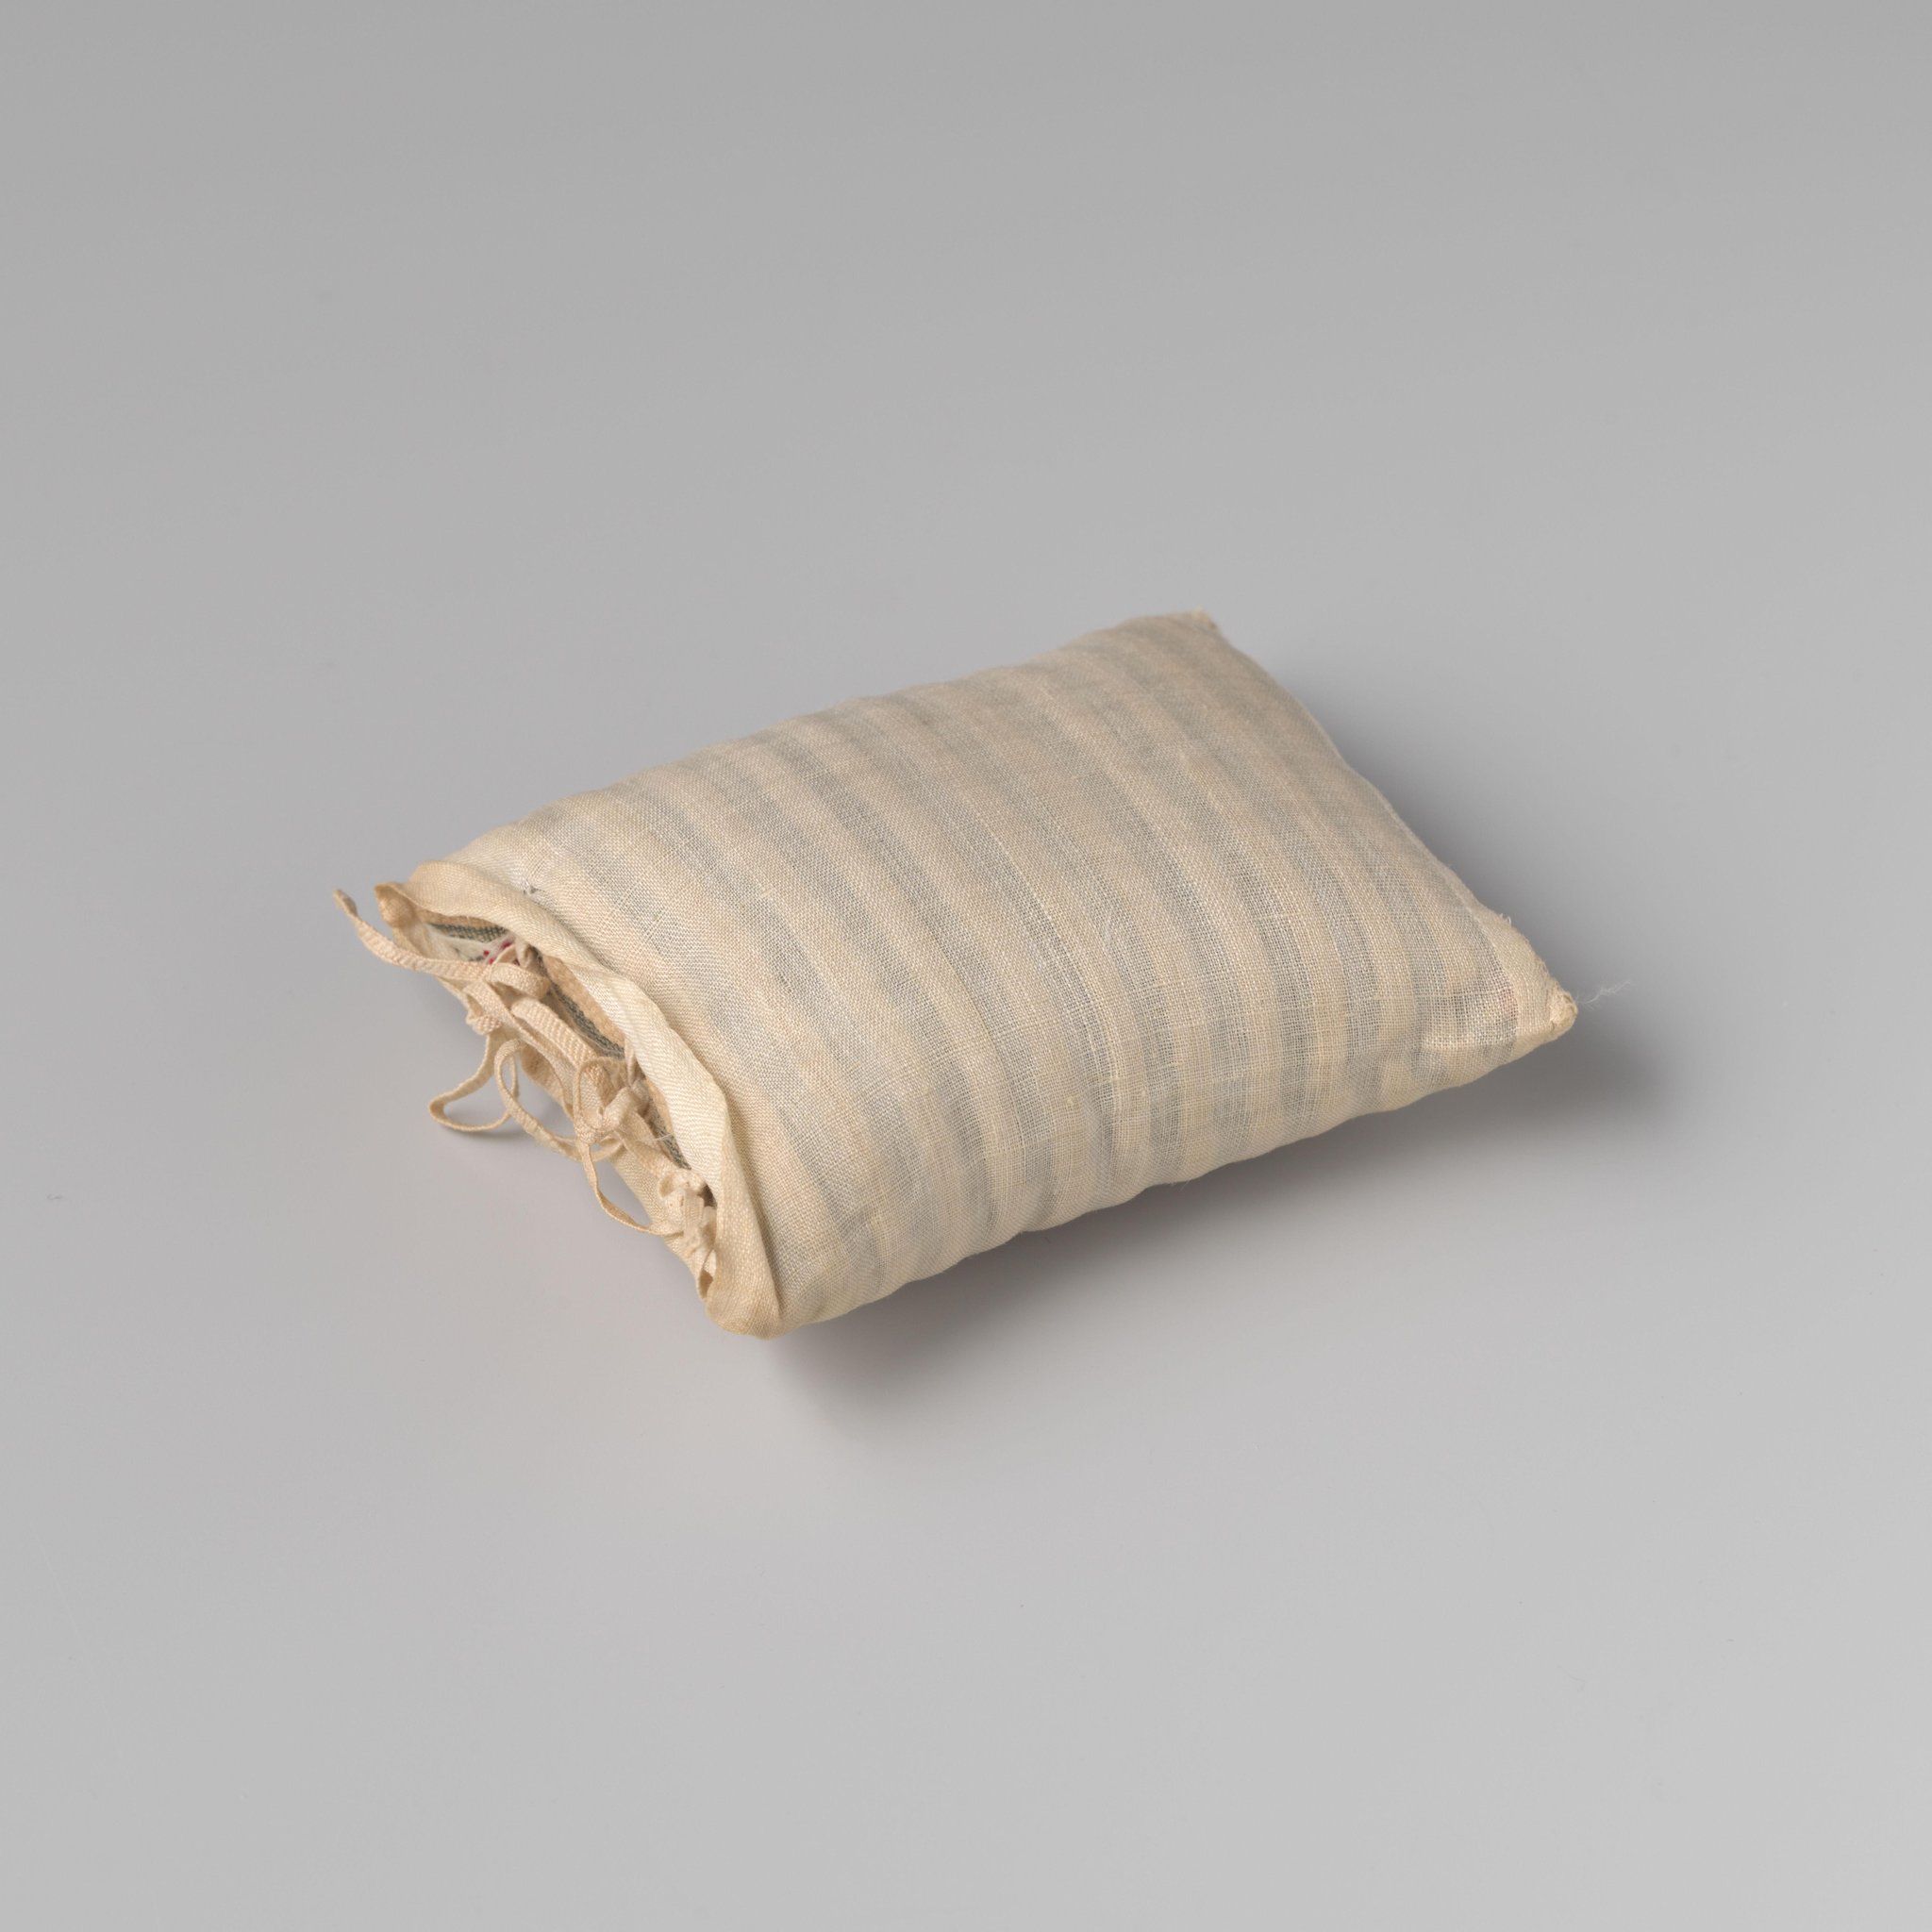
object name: miniature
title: Kussen van blauw-wit gestreept linnen / katoen weefsel; aan één korte zijde opgenaaide 'blinkerd' van lichtroze zijde; gevuld met dons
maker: Anonymous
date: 1690-1710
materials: cotton, down, linen, silk